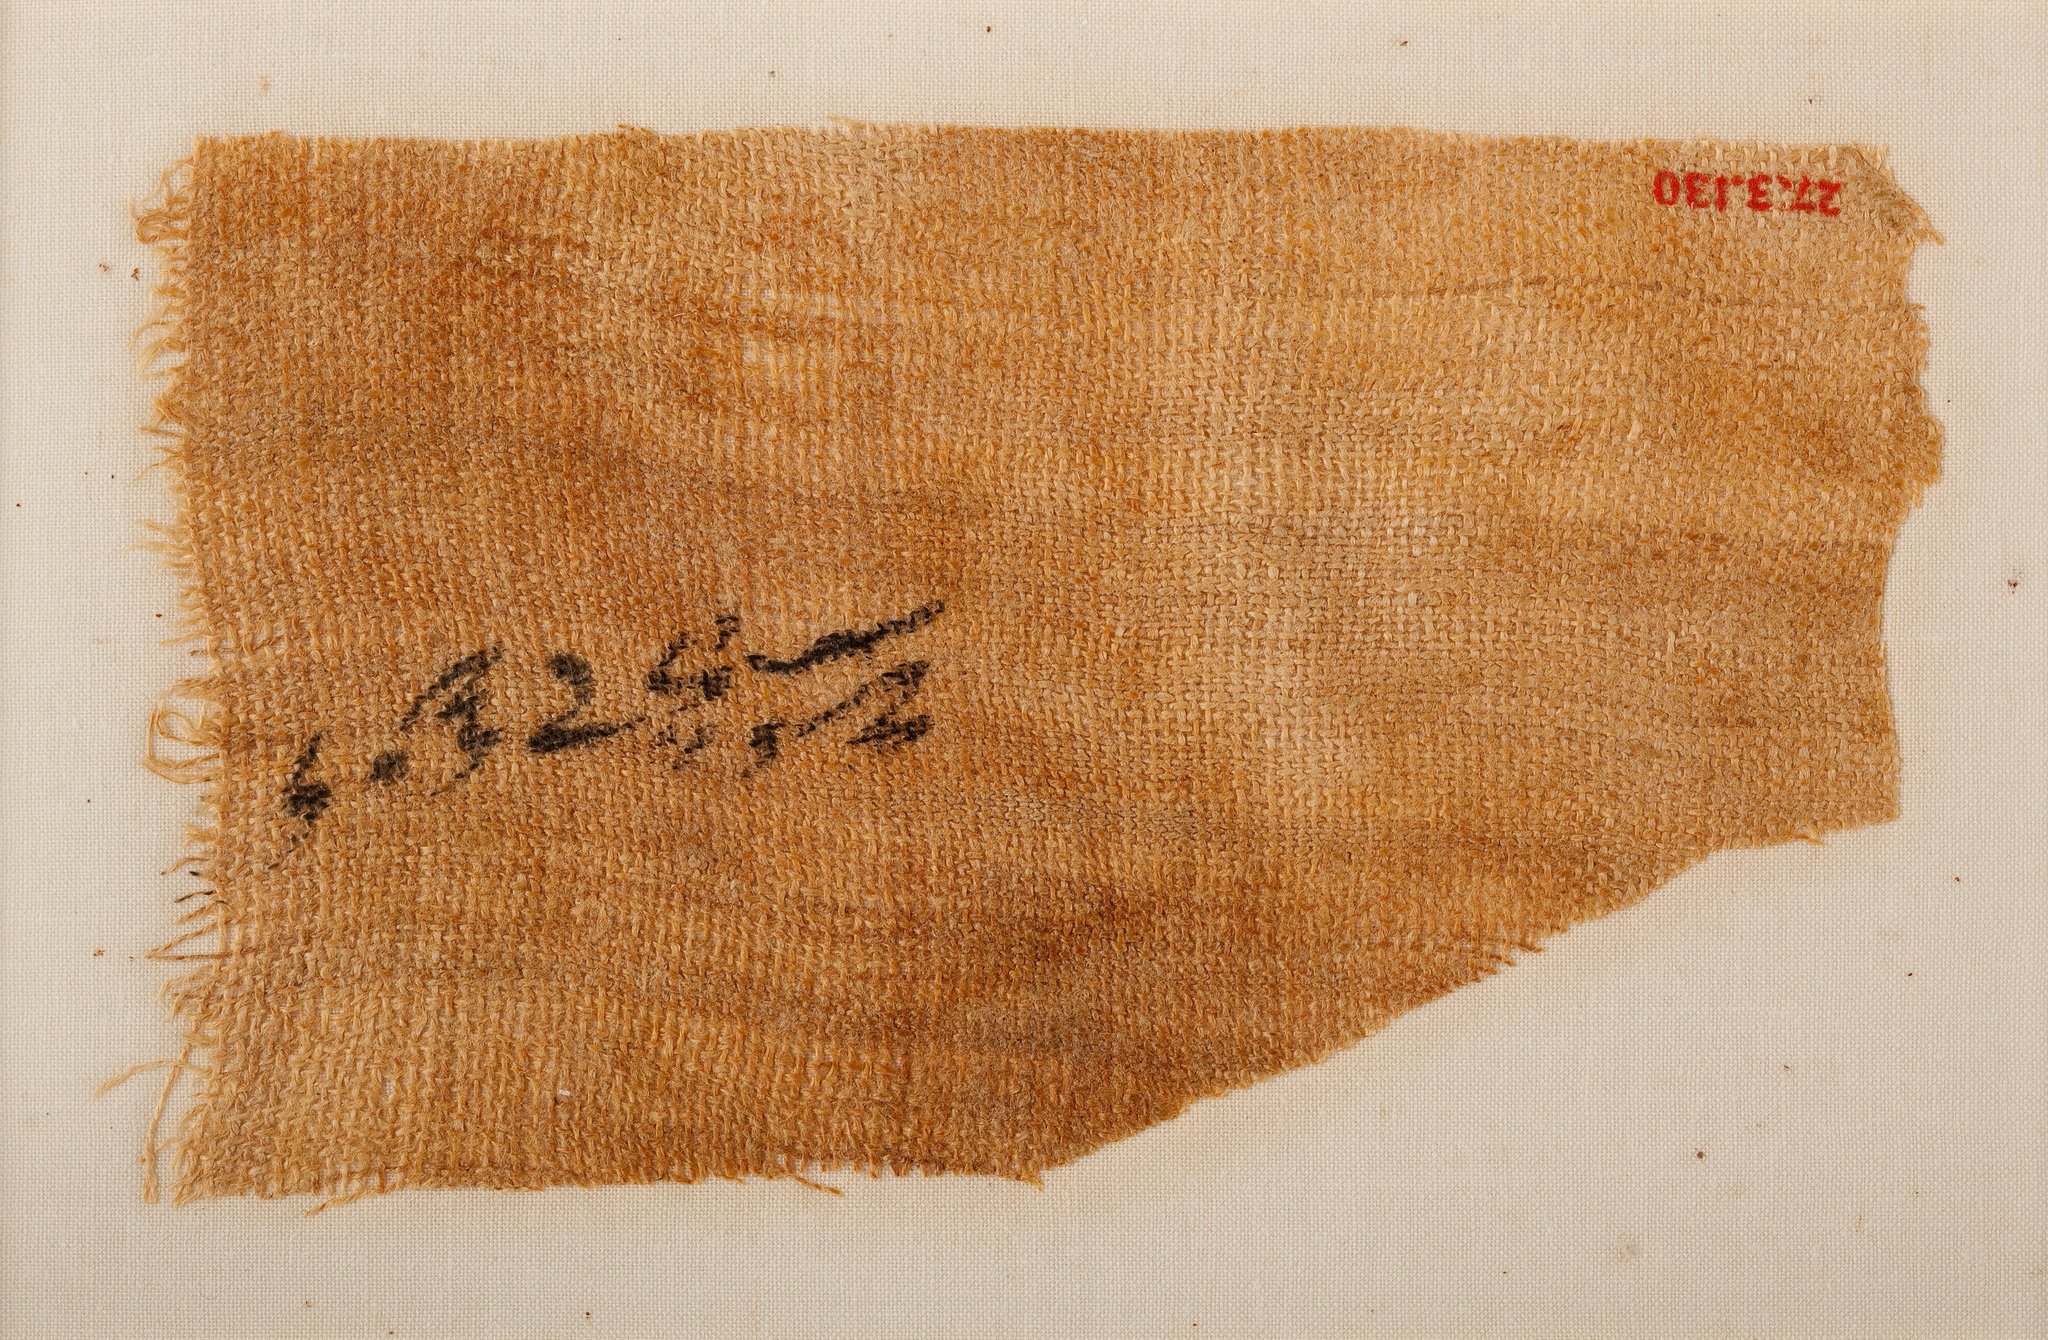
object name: linen mark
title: Linen mark (Type XXXII)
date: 1961-1917 BCE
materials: linen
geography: egypt